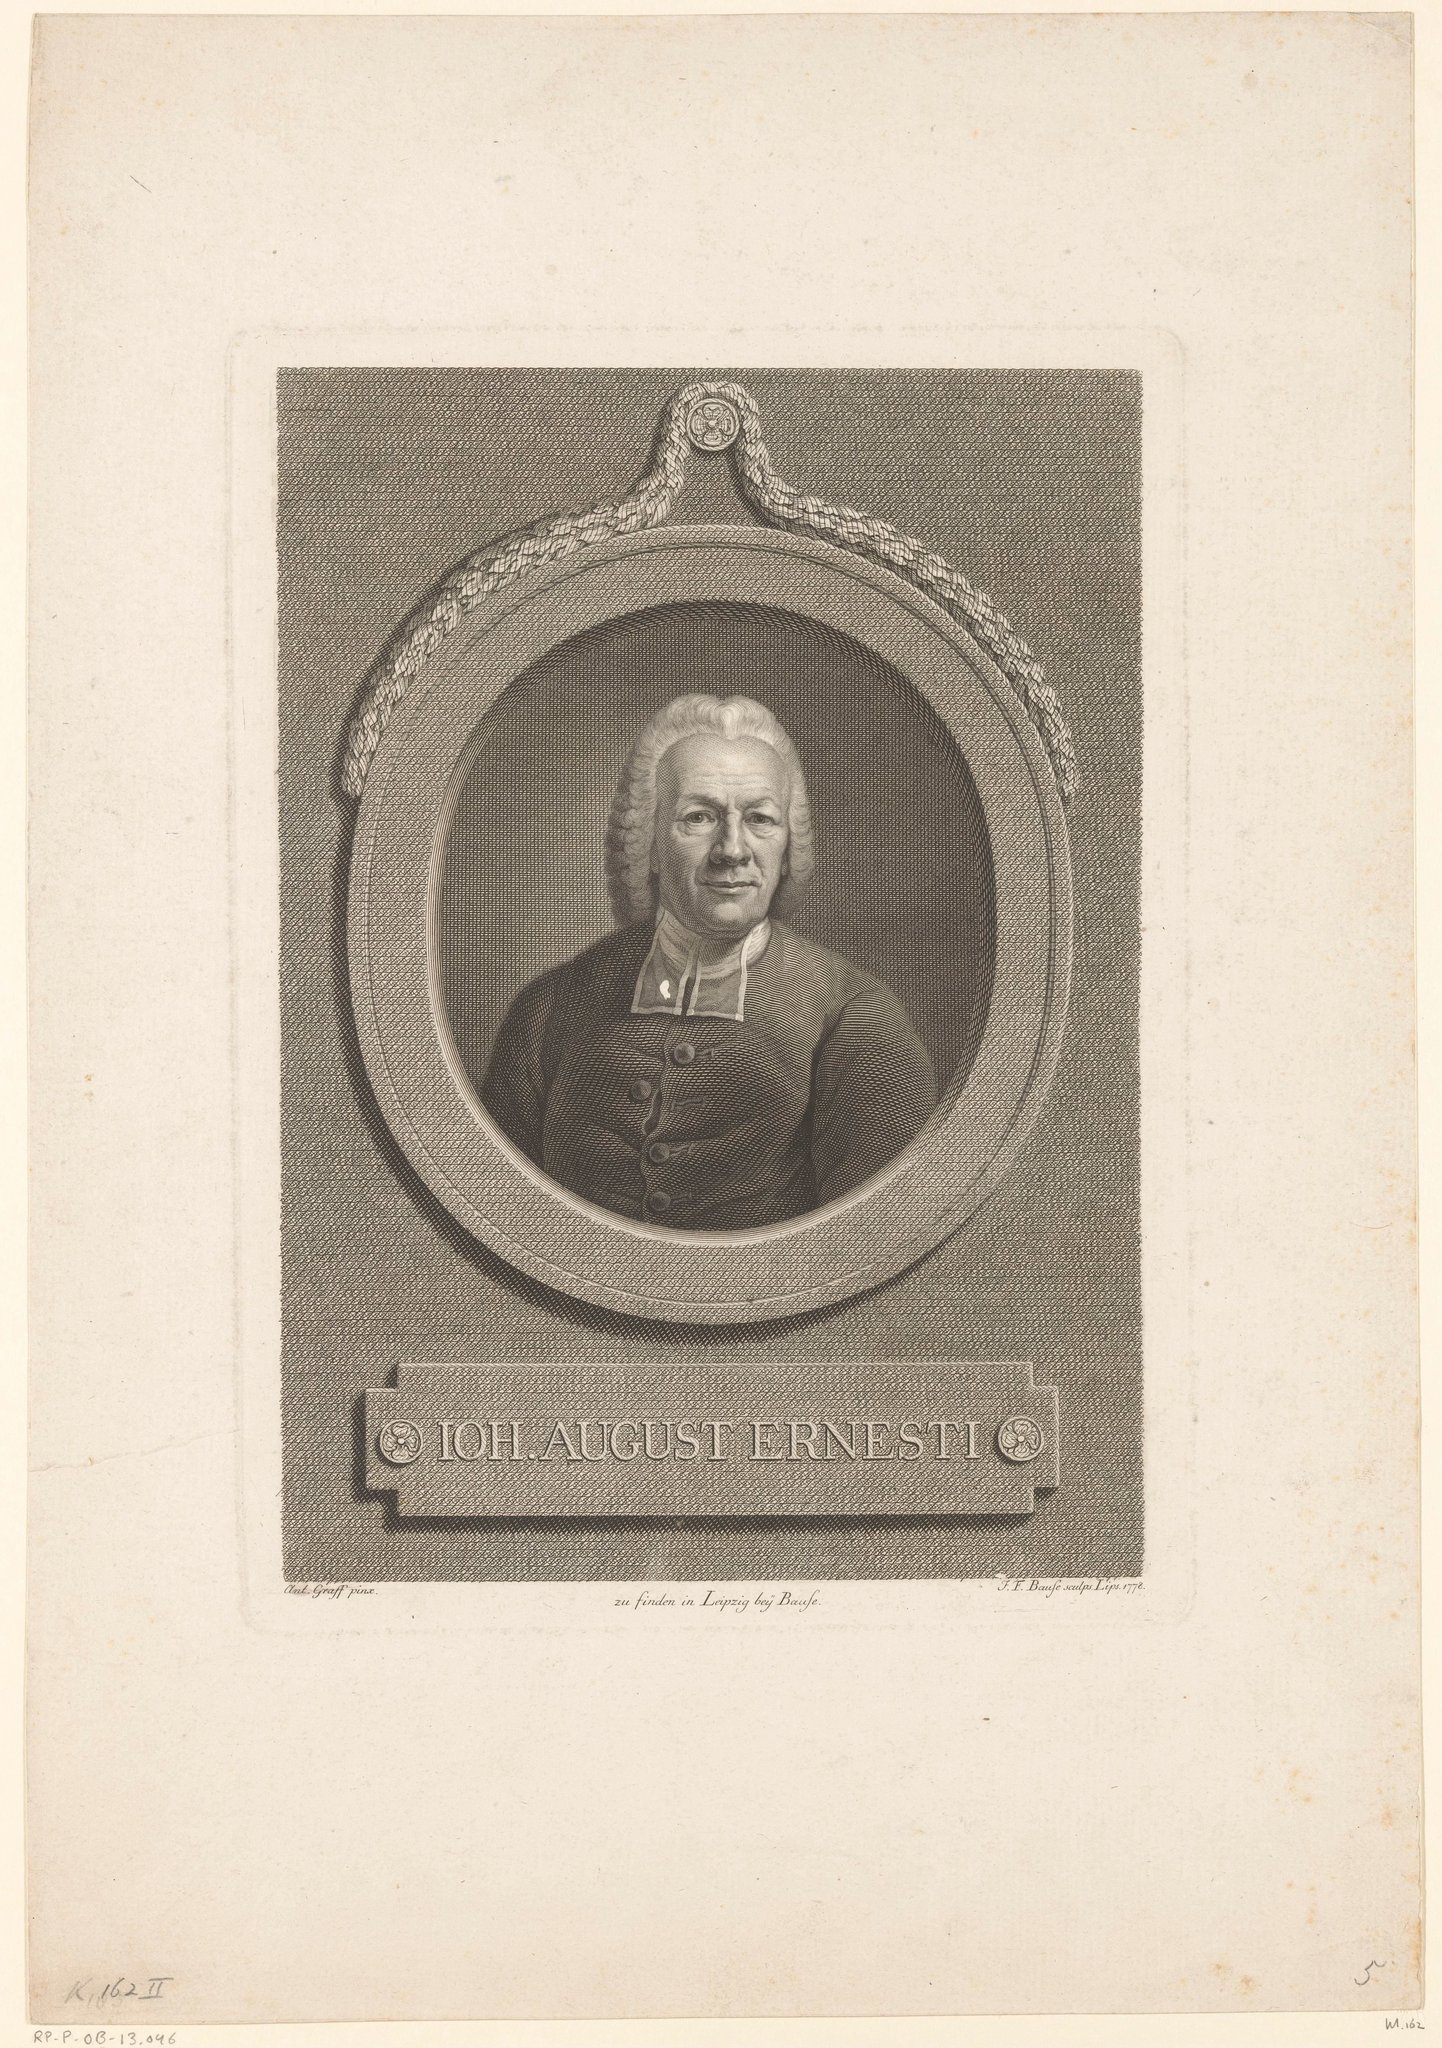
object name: print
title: Portret van Johann August Ernesti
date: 1778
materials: paper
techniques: engraving, etching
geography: leipzig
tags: historical persons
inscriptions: collector's mark: Lugt 240